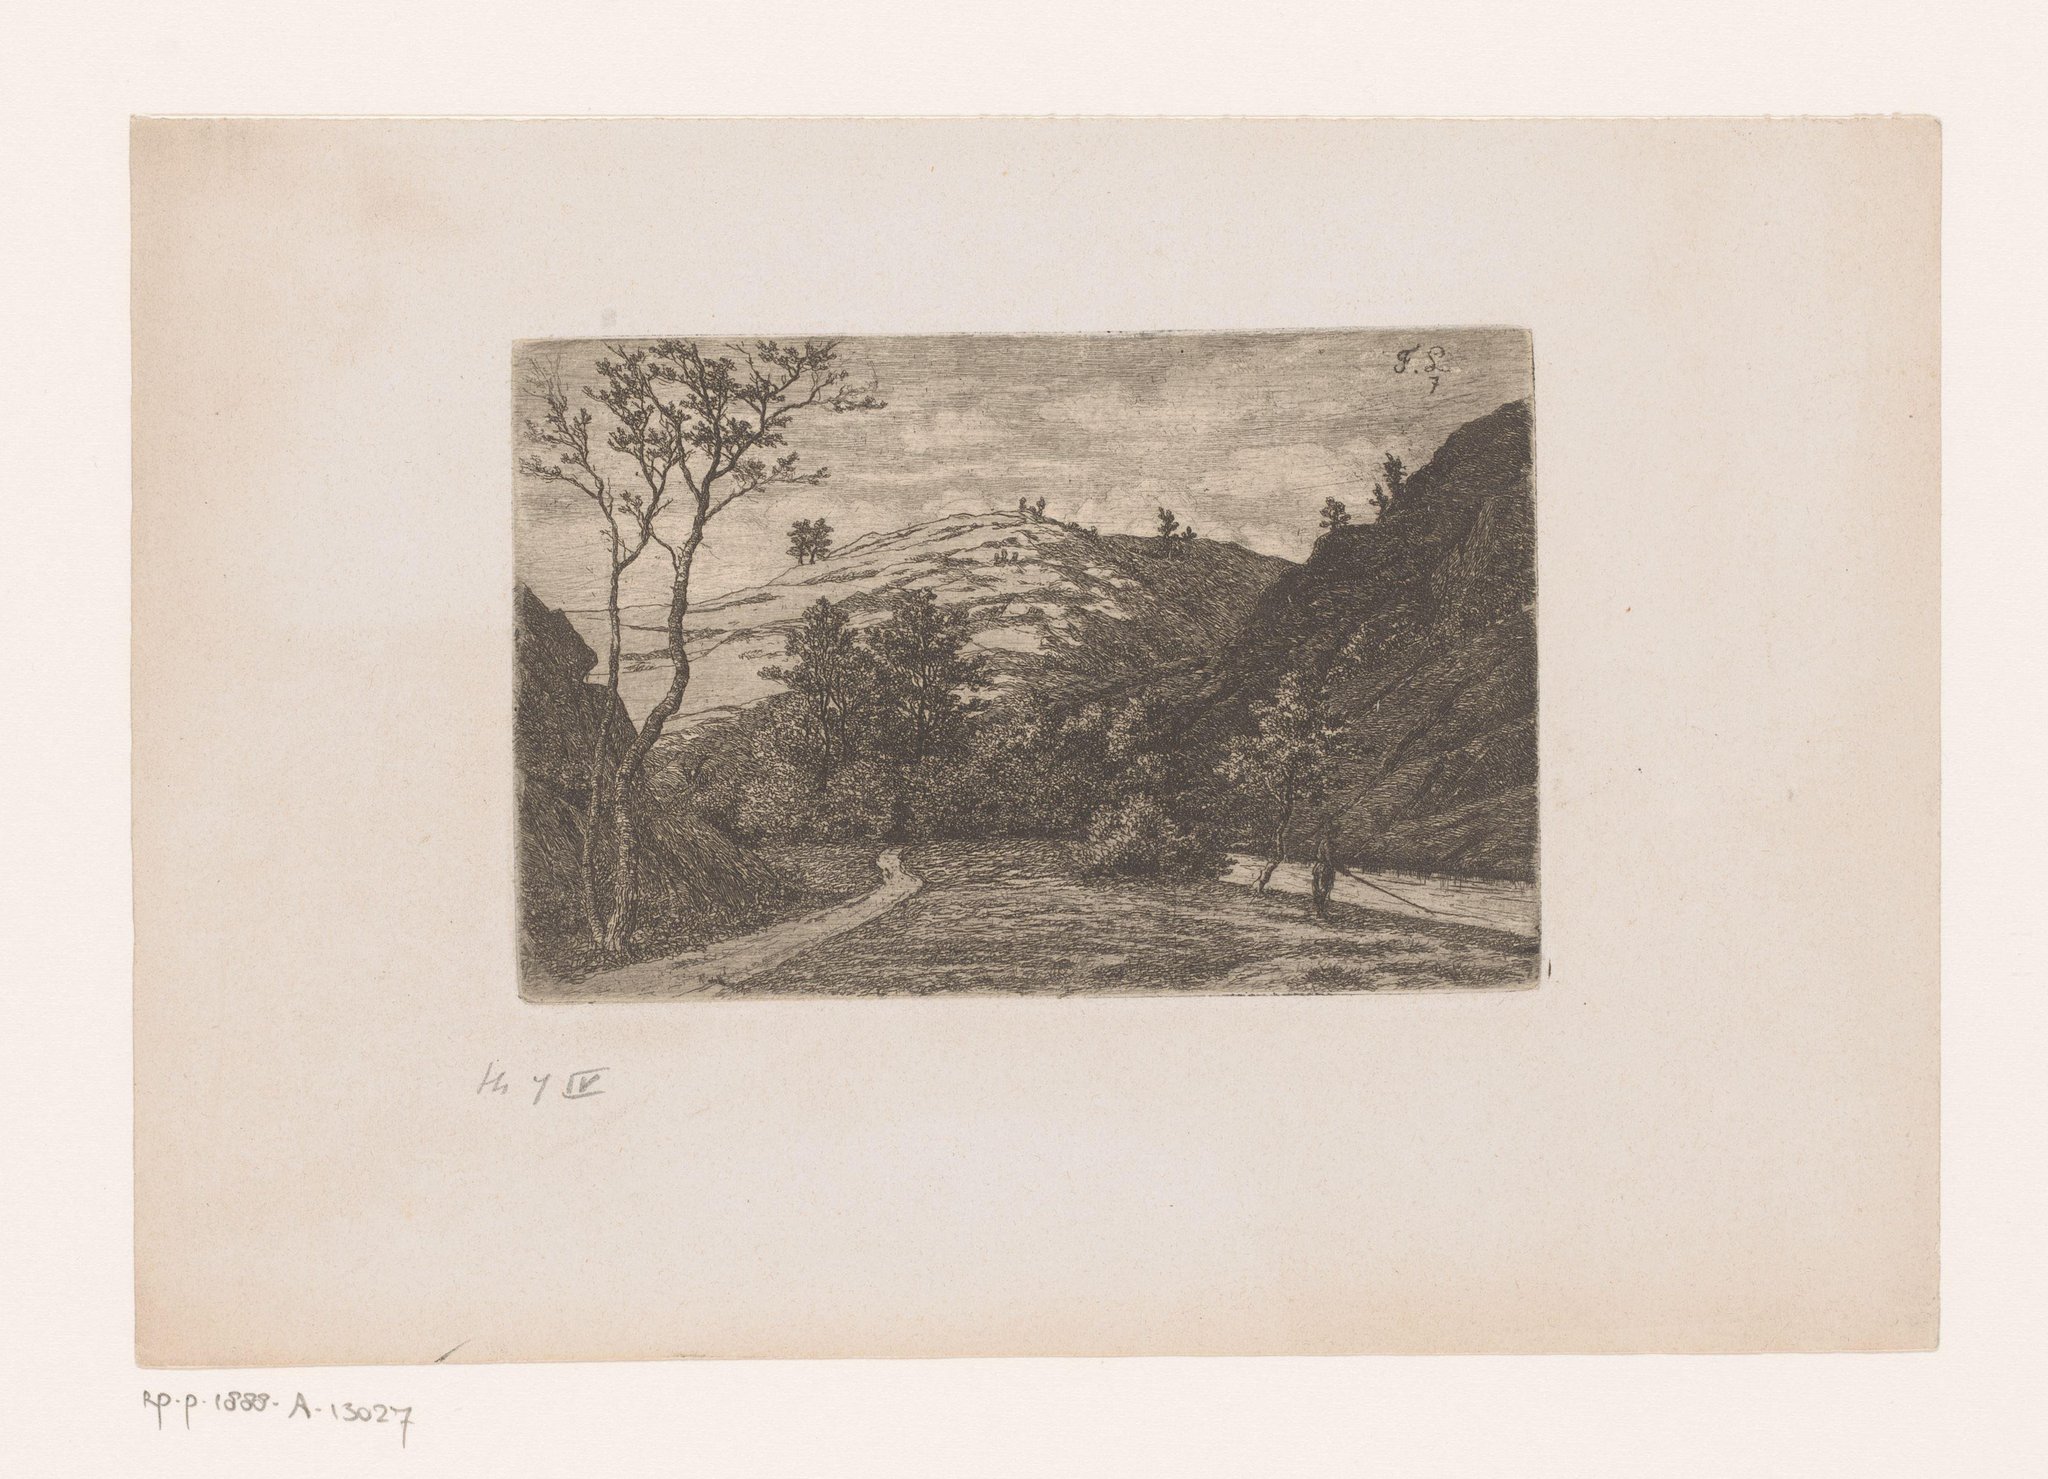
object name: print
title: Oevers van de rivier Lienne nabij Rahier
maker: jean pierre françois lamorinière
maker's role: print maker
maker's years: 1828-1911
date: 1838-1888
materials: paper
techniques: drypoint, etching, intaglio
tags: river, (high) hill, liège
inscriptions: collector's mark: Lugt 2228